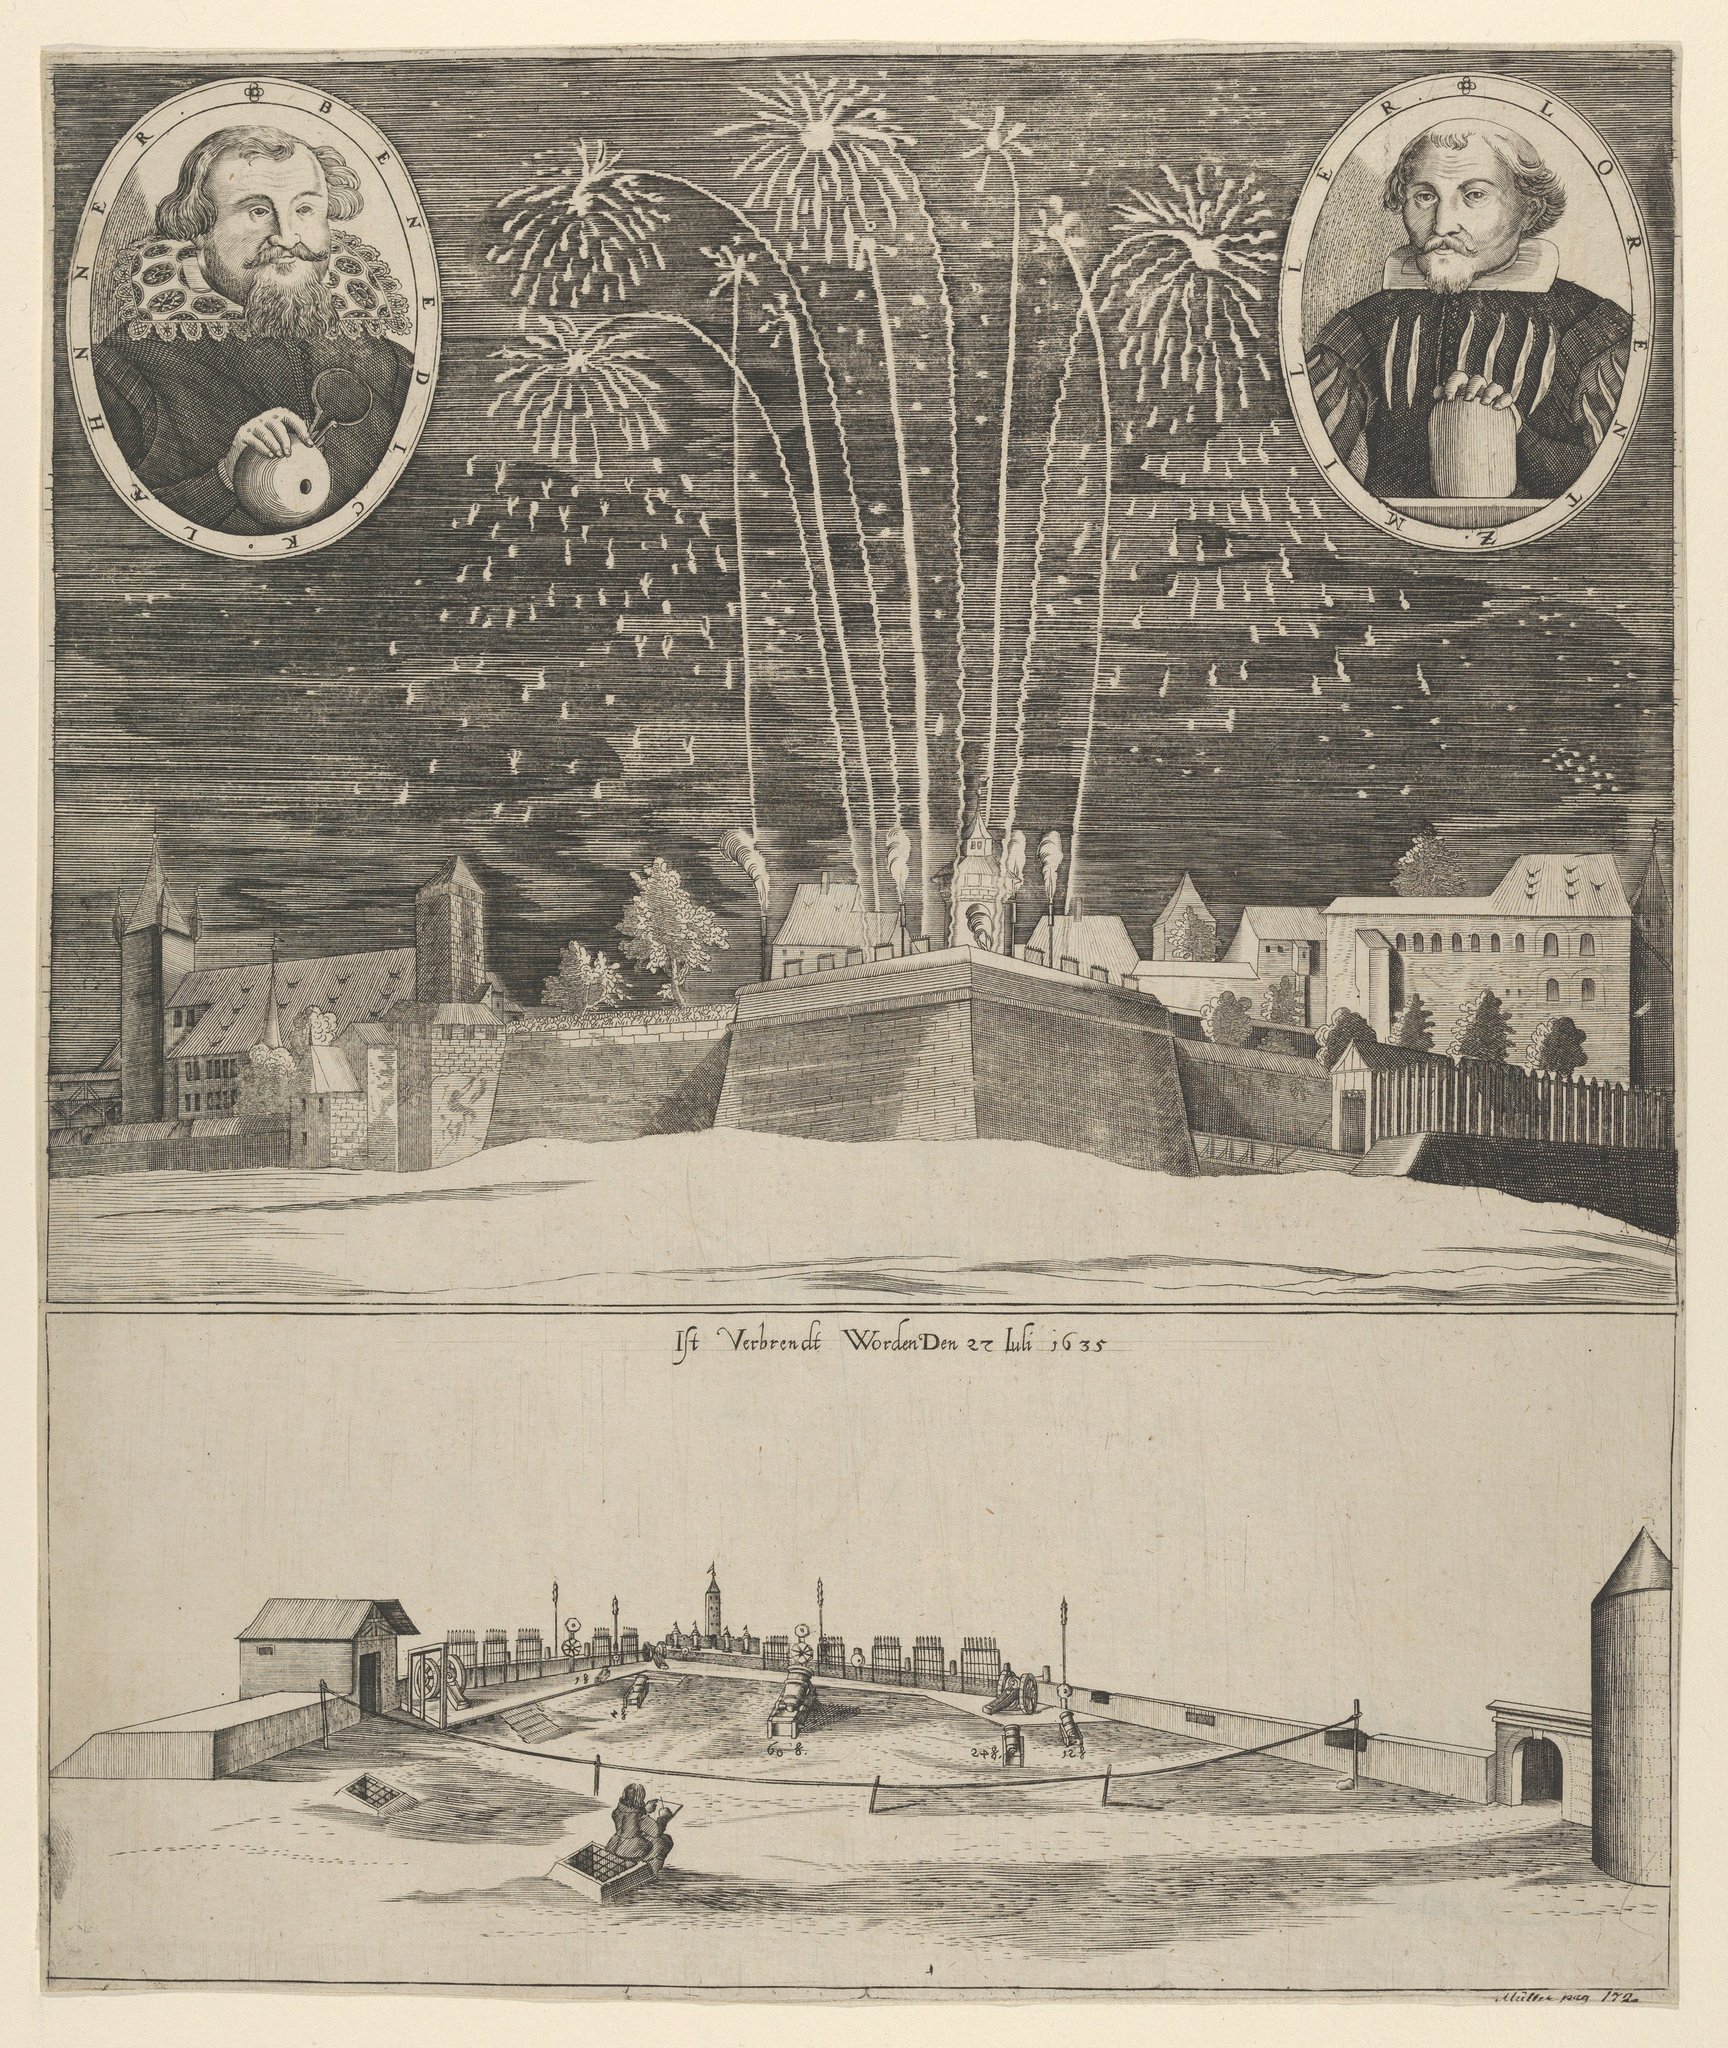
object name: print, fete, ornament architecture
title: Fireworks display by Lorenz Müller as proof of his mastership, Nuremberg 1635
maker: Anonymous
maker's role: artist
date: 1635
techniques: etching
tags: men,fireworks